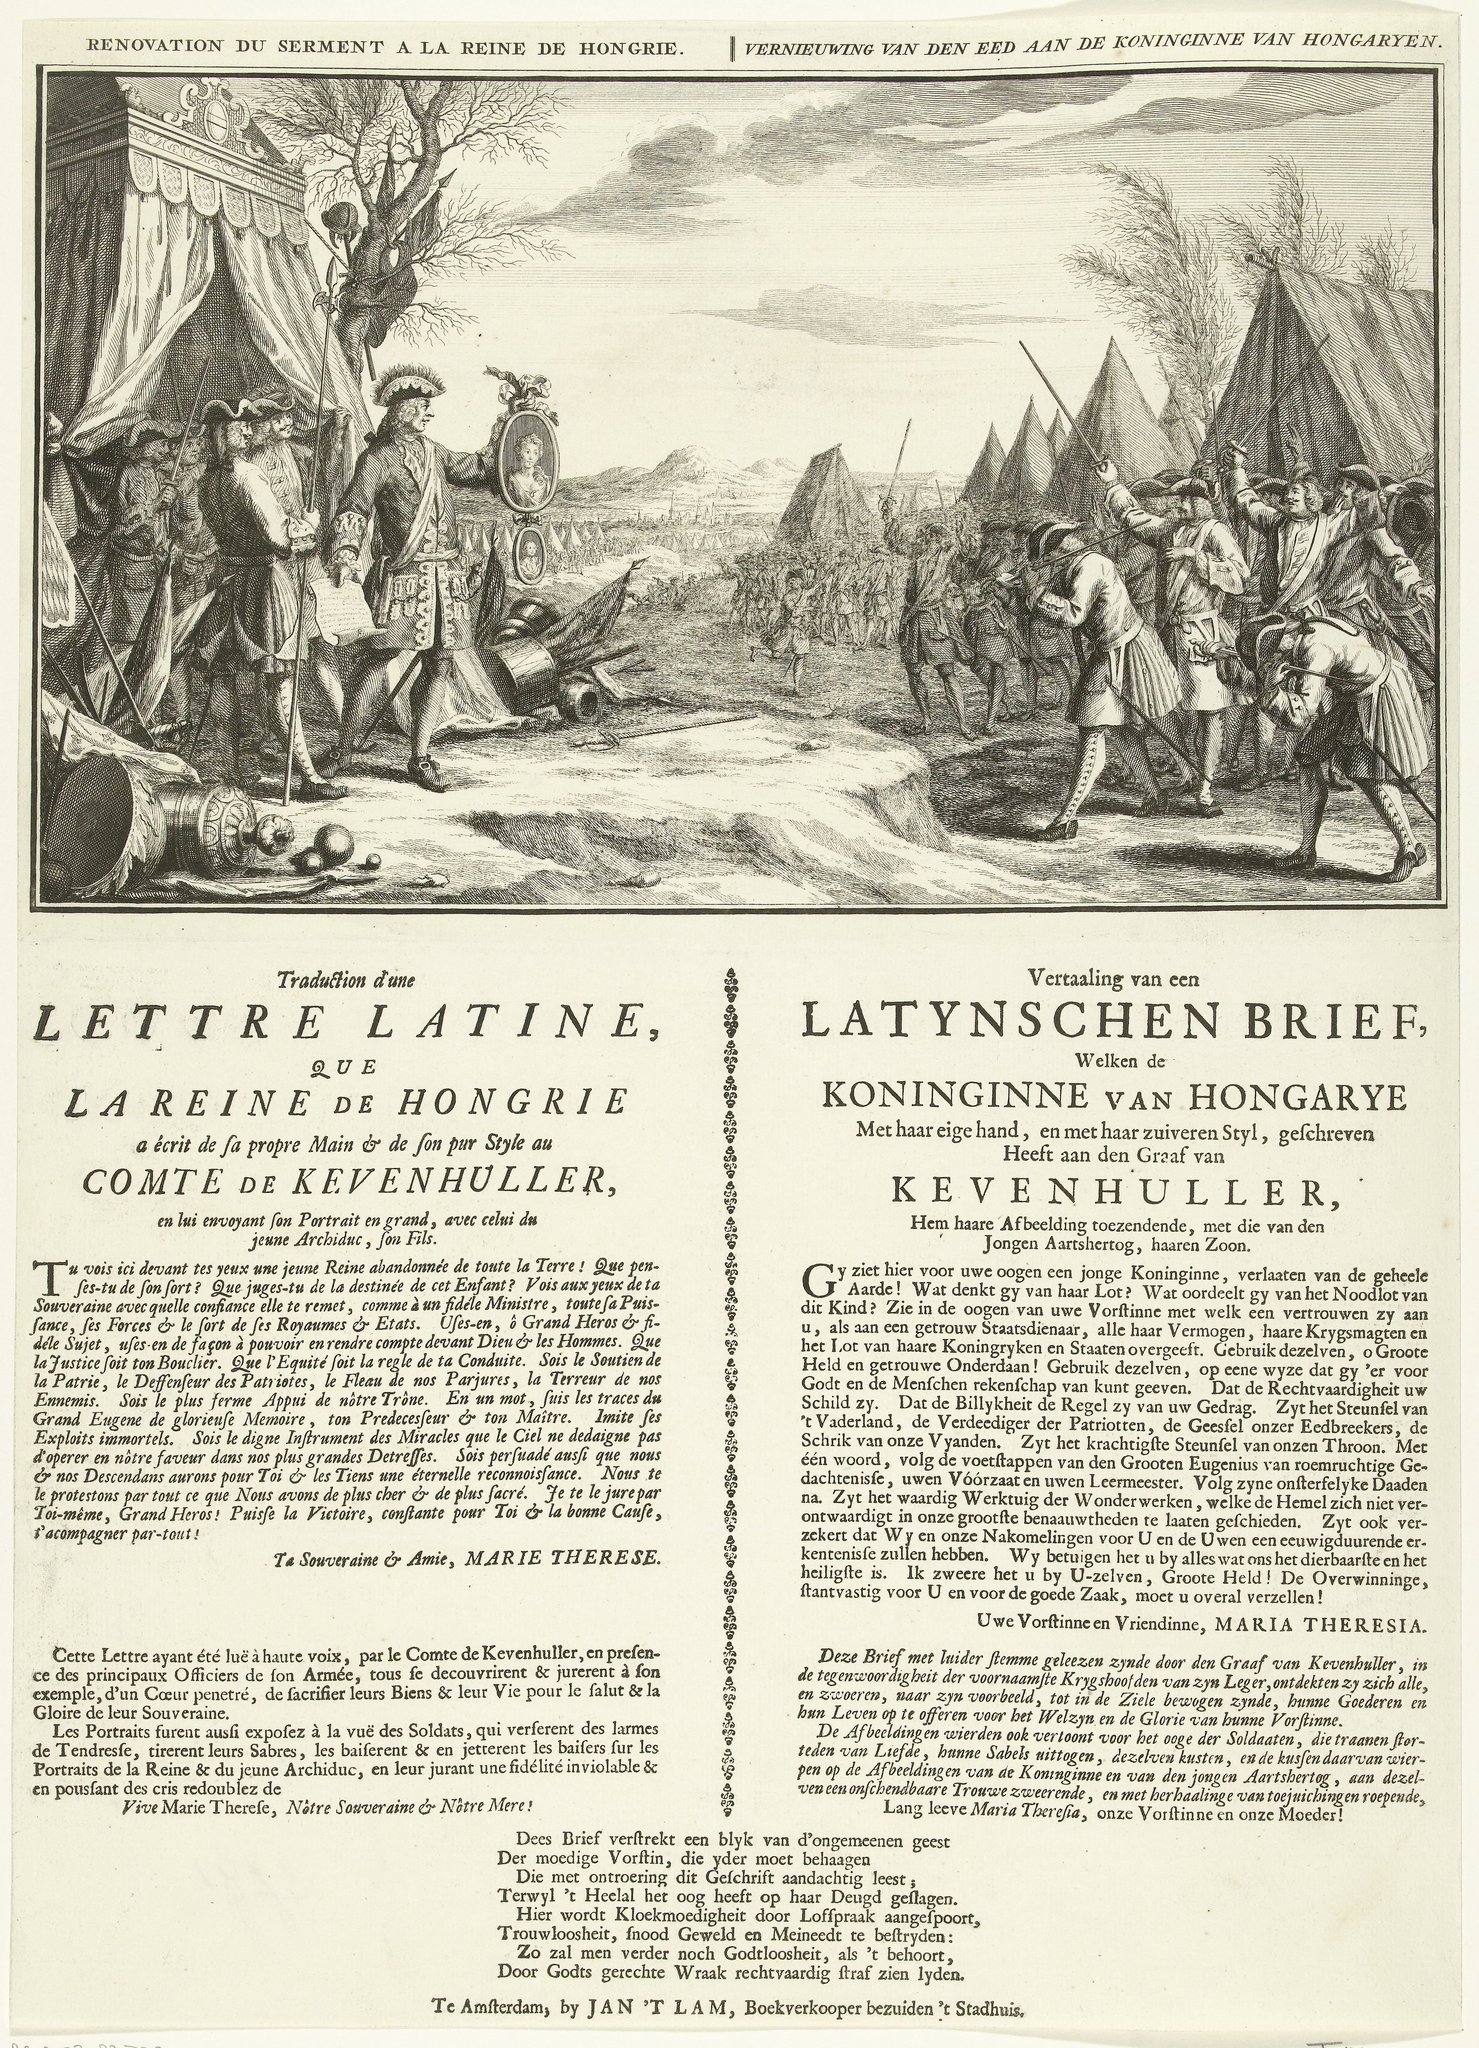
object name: print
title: Renovation du serment a la reine de Hongrie / Vernieuwing van den eed aan de koninginne van Hongaryen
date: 1742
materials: paper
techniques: engraving, etching, letterpress printing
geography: amsterdam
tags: vienna, ludwig andreas von khevenhüller, maria theresia (rooms-duits keizerin), jozef ii (duits keizer), (military) camp with tents, swearing allegiance to a ruler - bb - female ruler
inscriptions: collector's mark: Lugt 2228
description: Vernieuwing van de eed aan de koningin van Hongarije, februari 1742. Graaf Ludwig Andreas von Khevenhüller toont het door haar opgestuurde portret van aartshertogin Maria Theresia (koningin van Hongarije) en haar zoon Jozef aan de Oostenrijkse troepen in het legerkamp. DE militairen juichen en zweren trouw aan de vorstin. Op het blad onder de plaat een vertaling van de door haar meegezonden brief in het Frans en Nederlands.